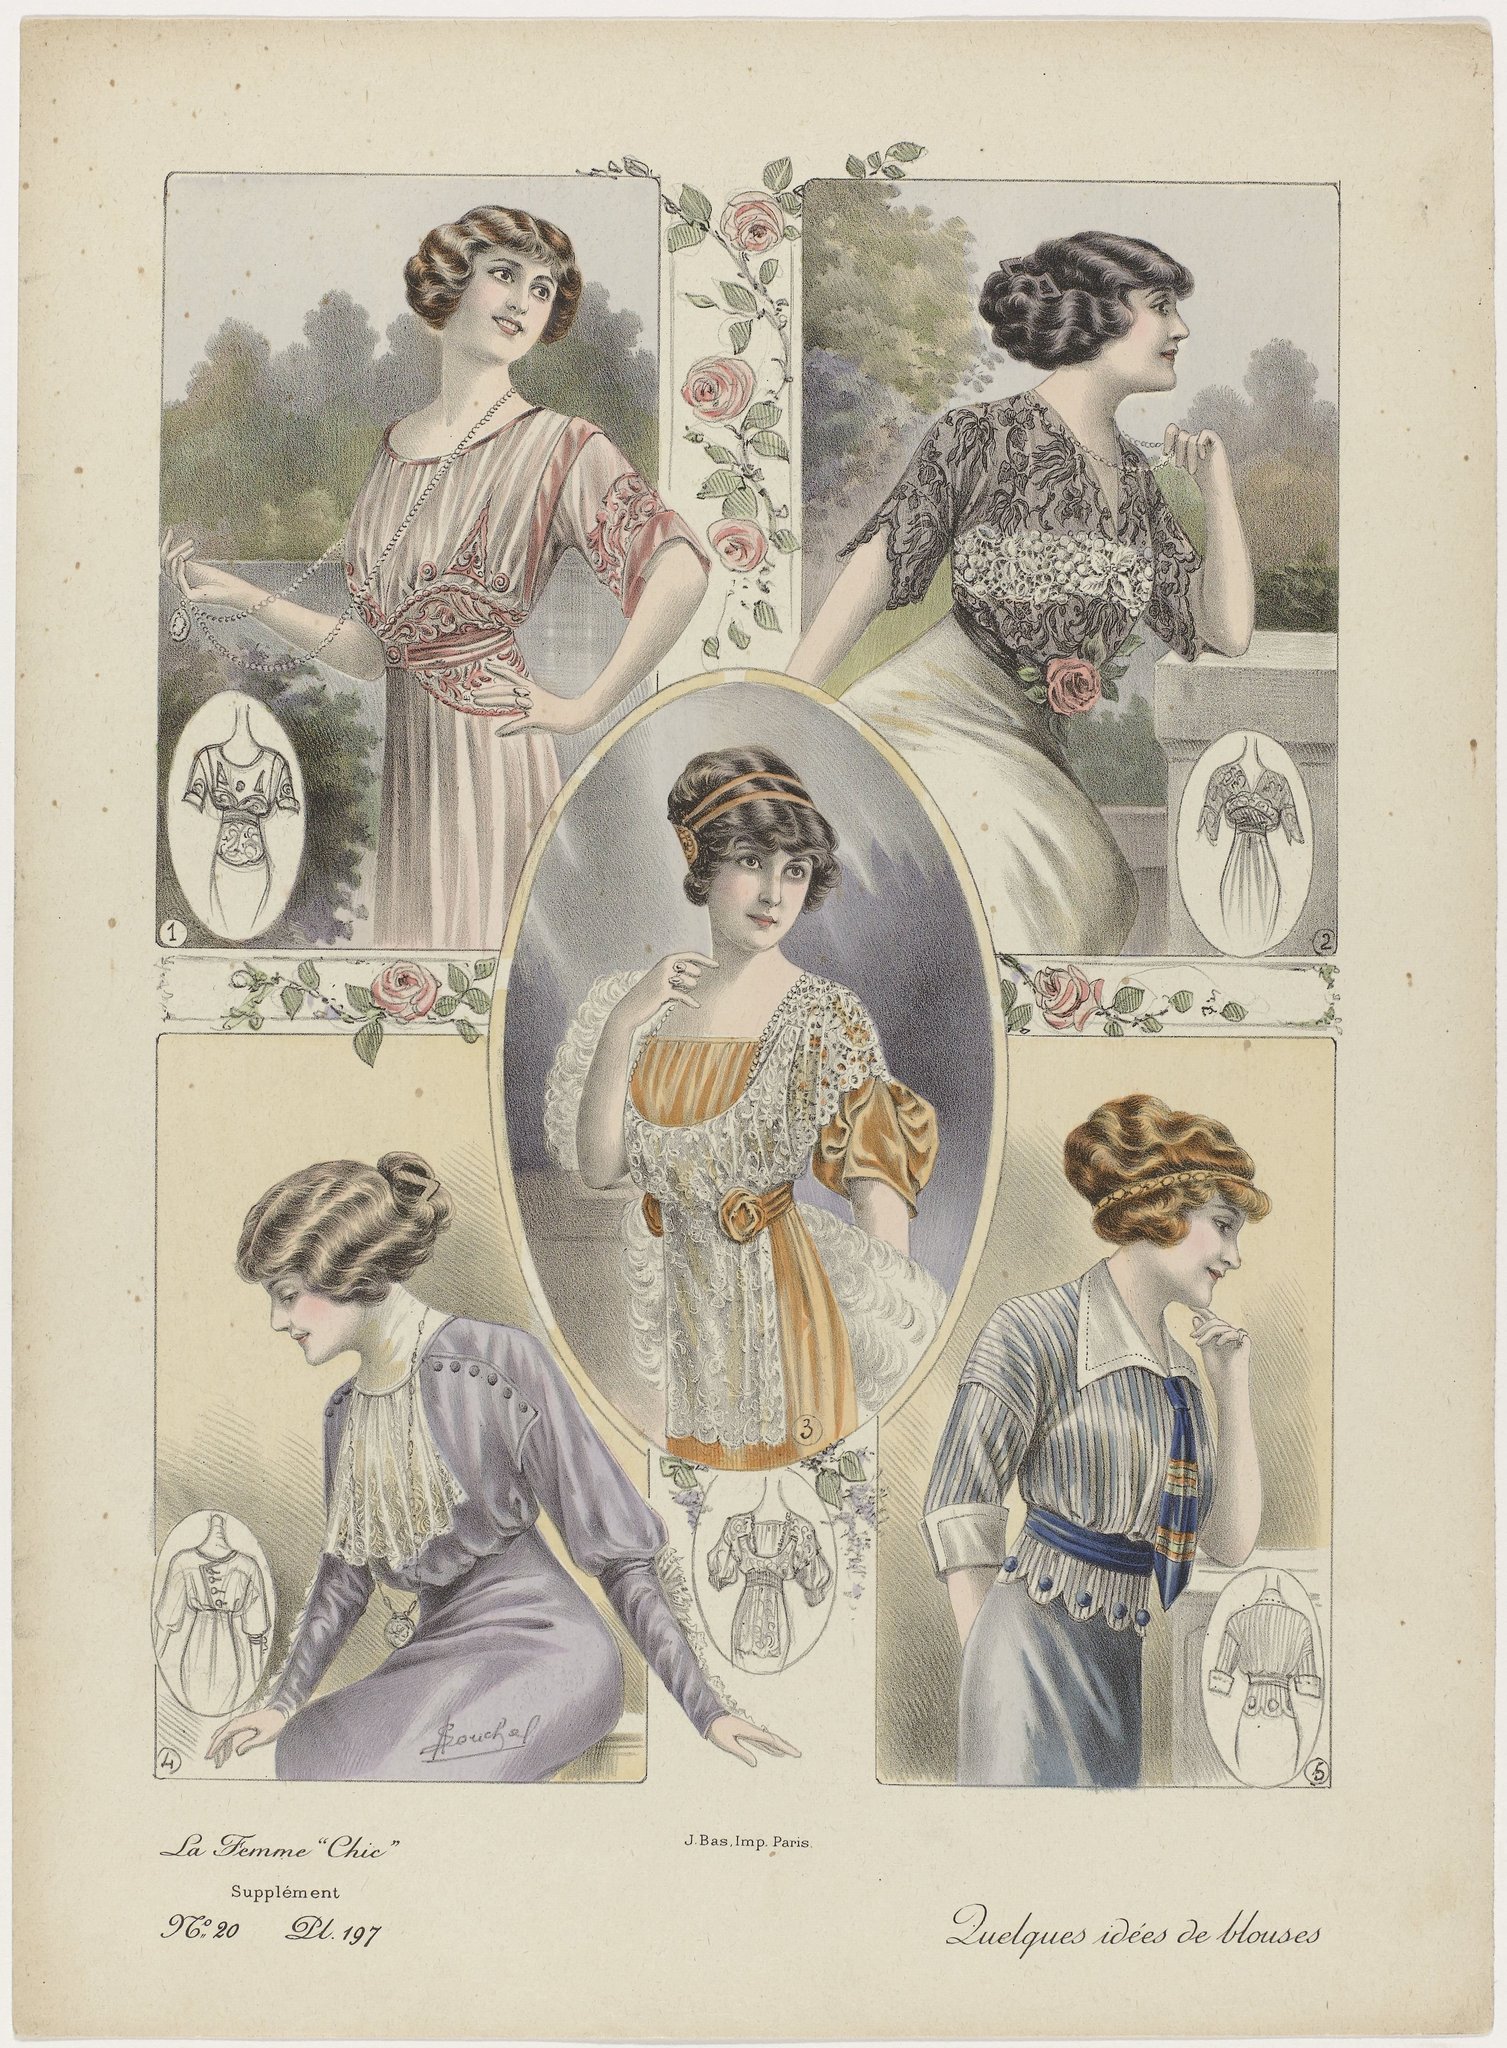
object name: fashion print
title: La Femme chic, Supplément, 1911, No. 20, Pl. 197 : Quelques idées de blouses (...)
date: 1911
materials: paper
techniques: hand coloring, lithograph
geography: paris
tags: pendant, trinket, 'breloque' (+ women's clothes), clothing for the upper part of the body: blouse (+ women's clothes), neck-gear ~ clothing (tie) (+ women's clothes), fashion plates, flowers: rose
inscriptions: title: ‘La Femme "Chic" / Supplément / No 20 Pl. 197’, caption: ‘Quelques idées de blouses’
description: Vijf verschillende blouses, met kleine lijntekening van de achterzijde. Verdere accessoires: collier met hanger, bloemcorsage, haarband, stola en das. Prent uit het modetijdschrift La Femme chic (1911-1971)